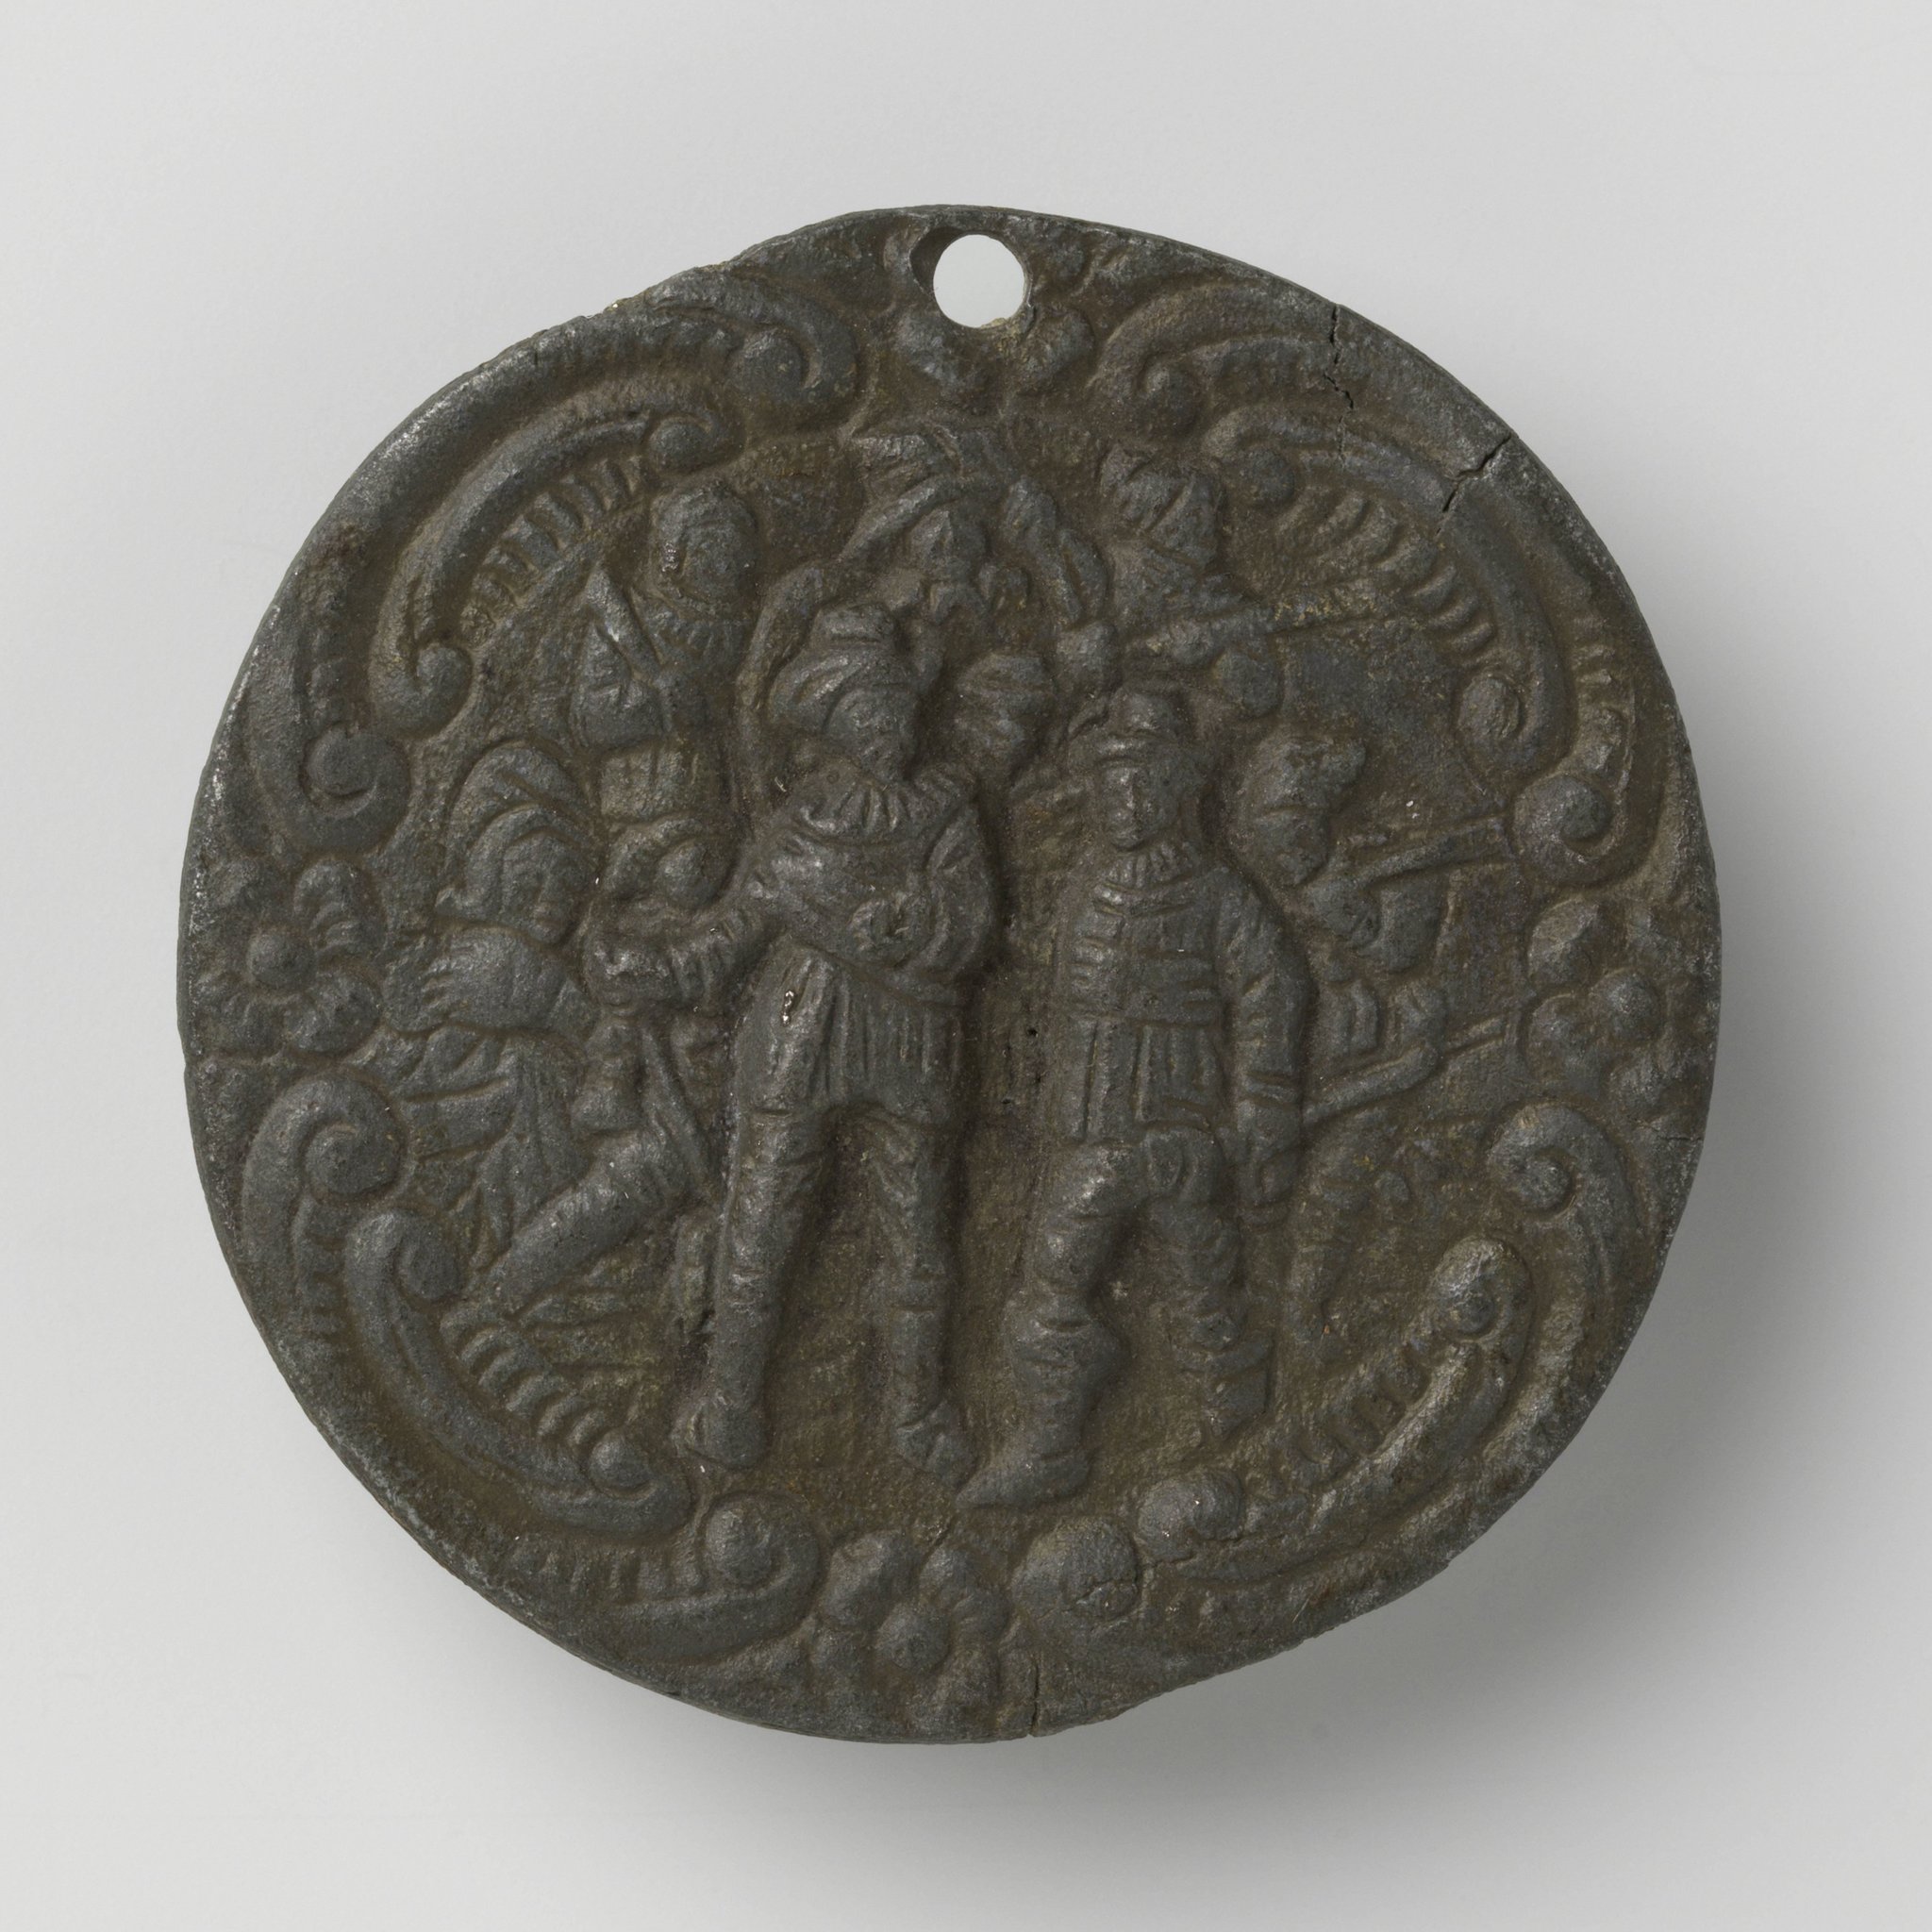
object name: plaque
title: Het hoofdmotief van de Nachtwacht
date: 1899-1999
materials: lead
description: Ronde loden plaque met het hoofdmotief uit de "Nachtwacht" van Rembrandt in relief.